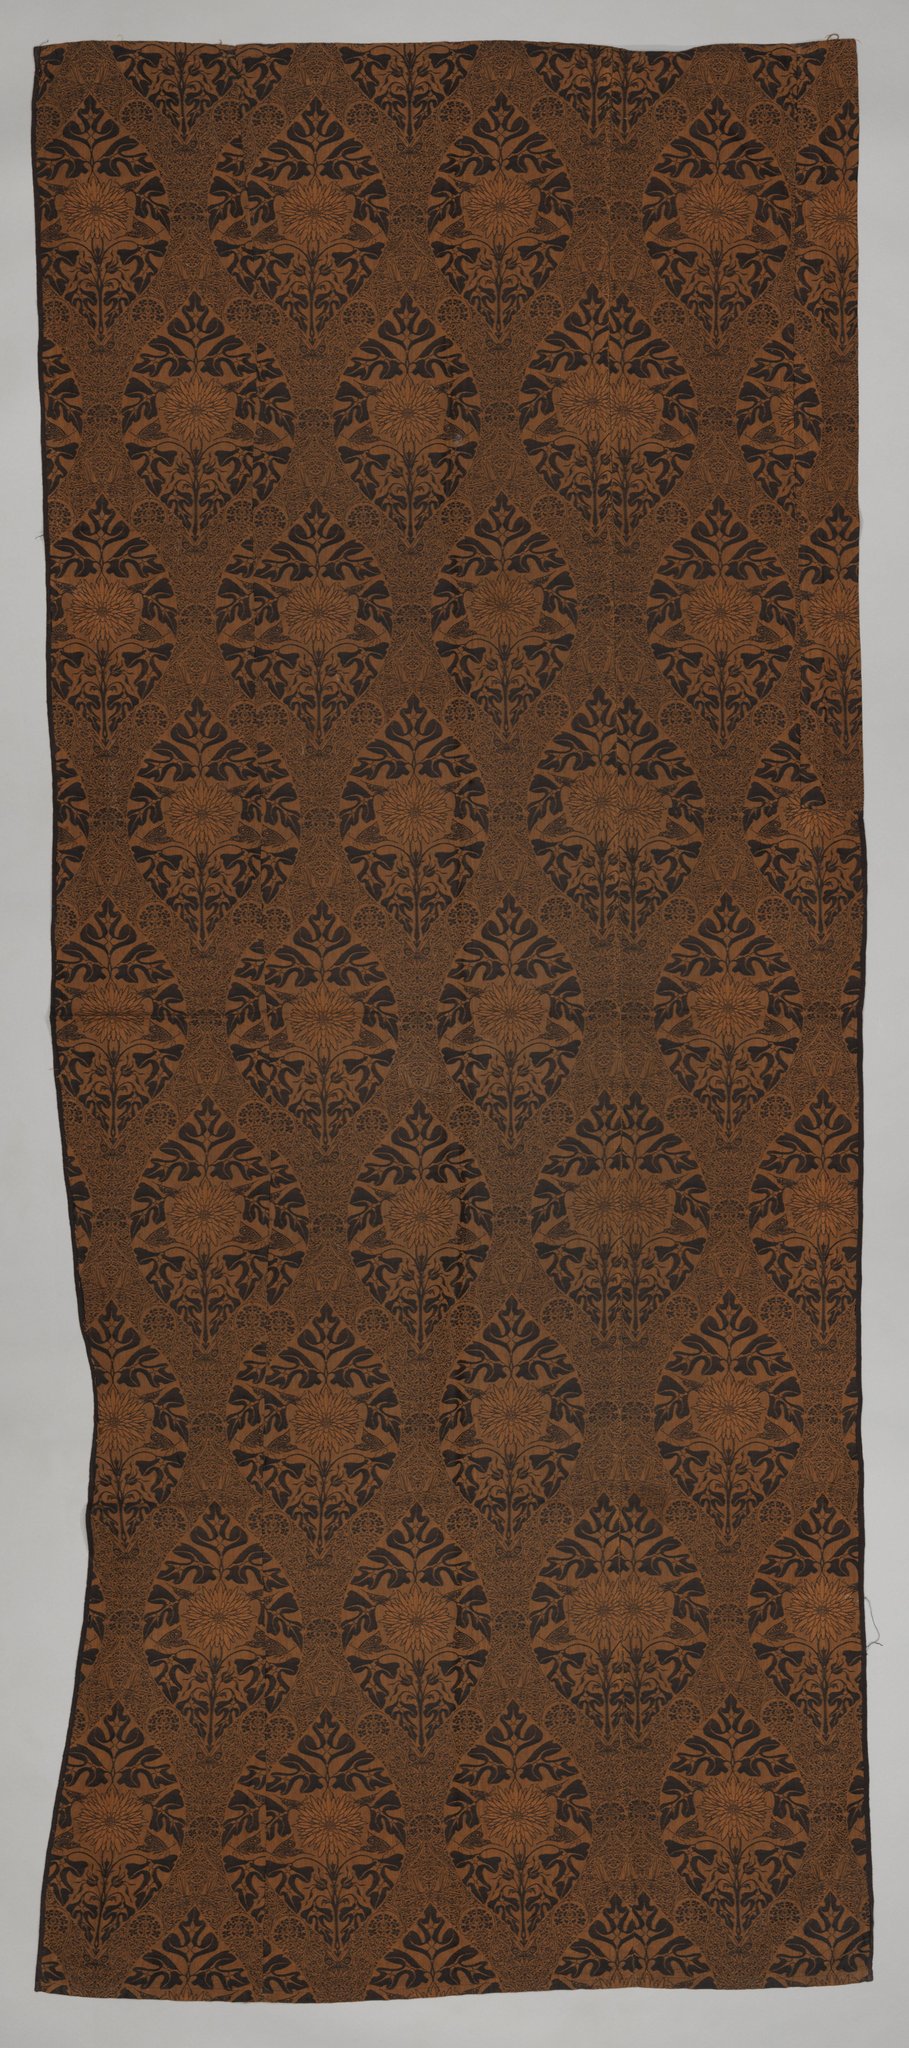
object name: curtain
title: Gordijn met patroon van bloem binnen brede spitsovale banden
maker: theo nieuwenhuis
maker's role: designer, draughtsman, print maker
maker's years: 1866-1951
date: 1900-1925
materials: cotton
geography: netherlands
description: Gordijn met patroon van bloem binnen brede spitsovale banden. Zwarte inslag op gele ketting.